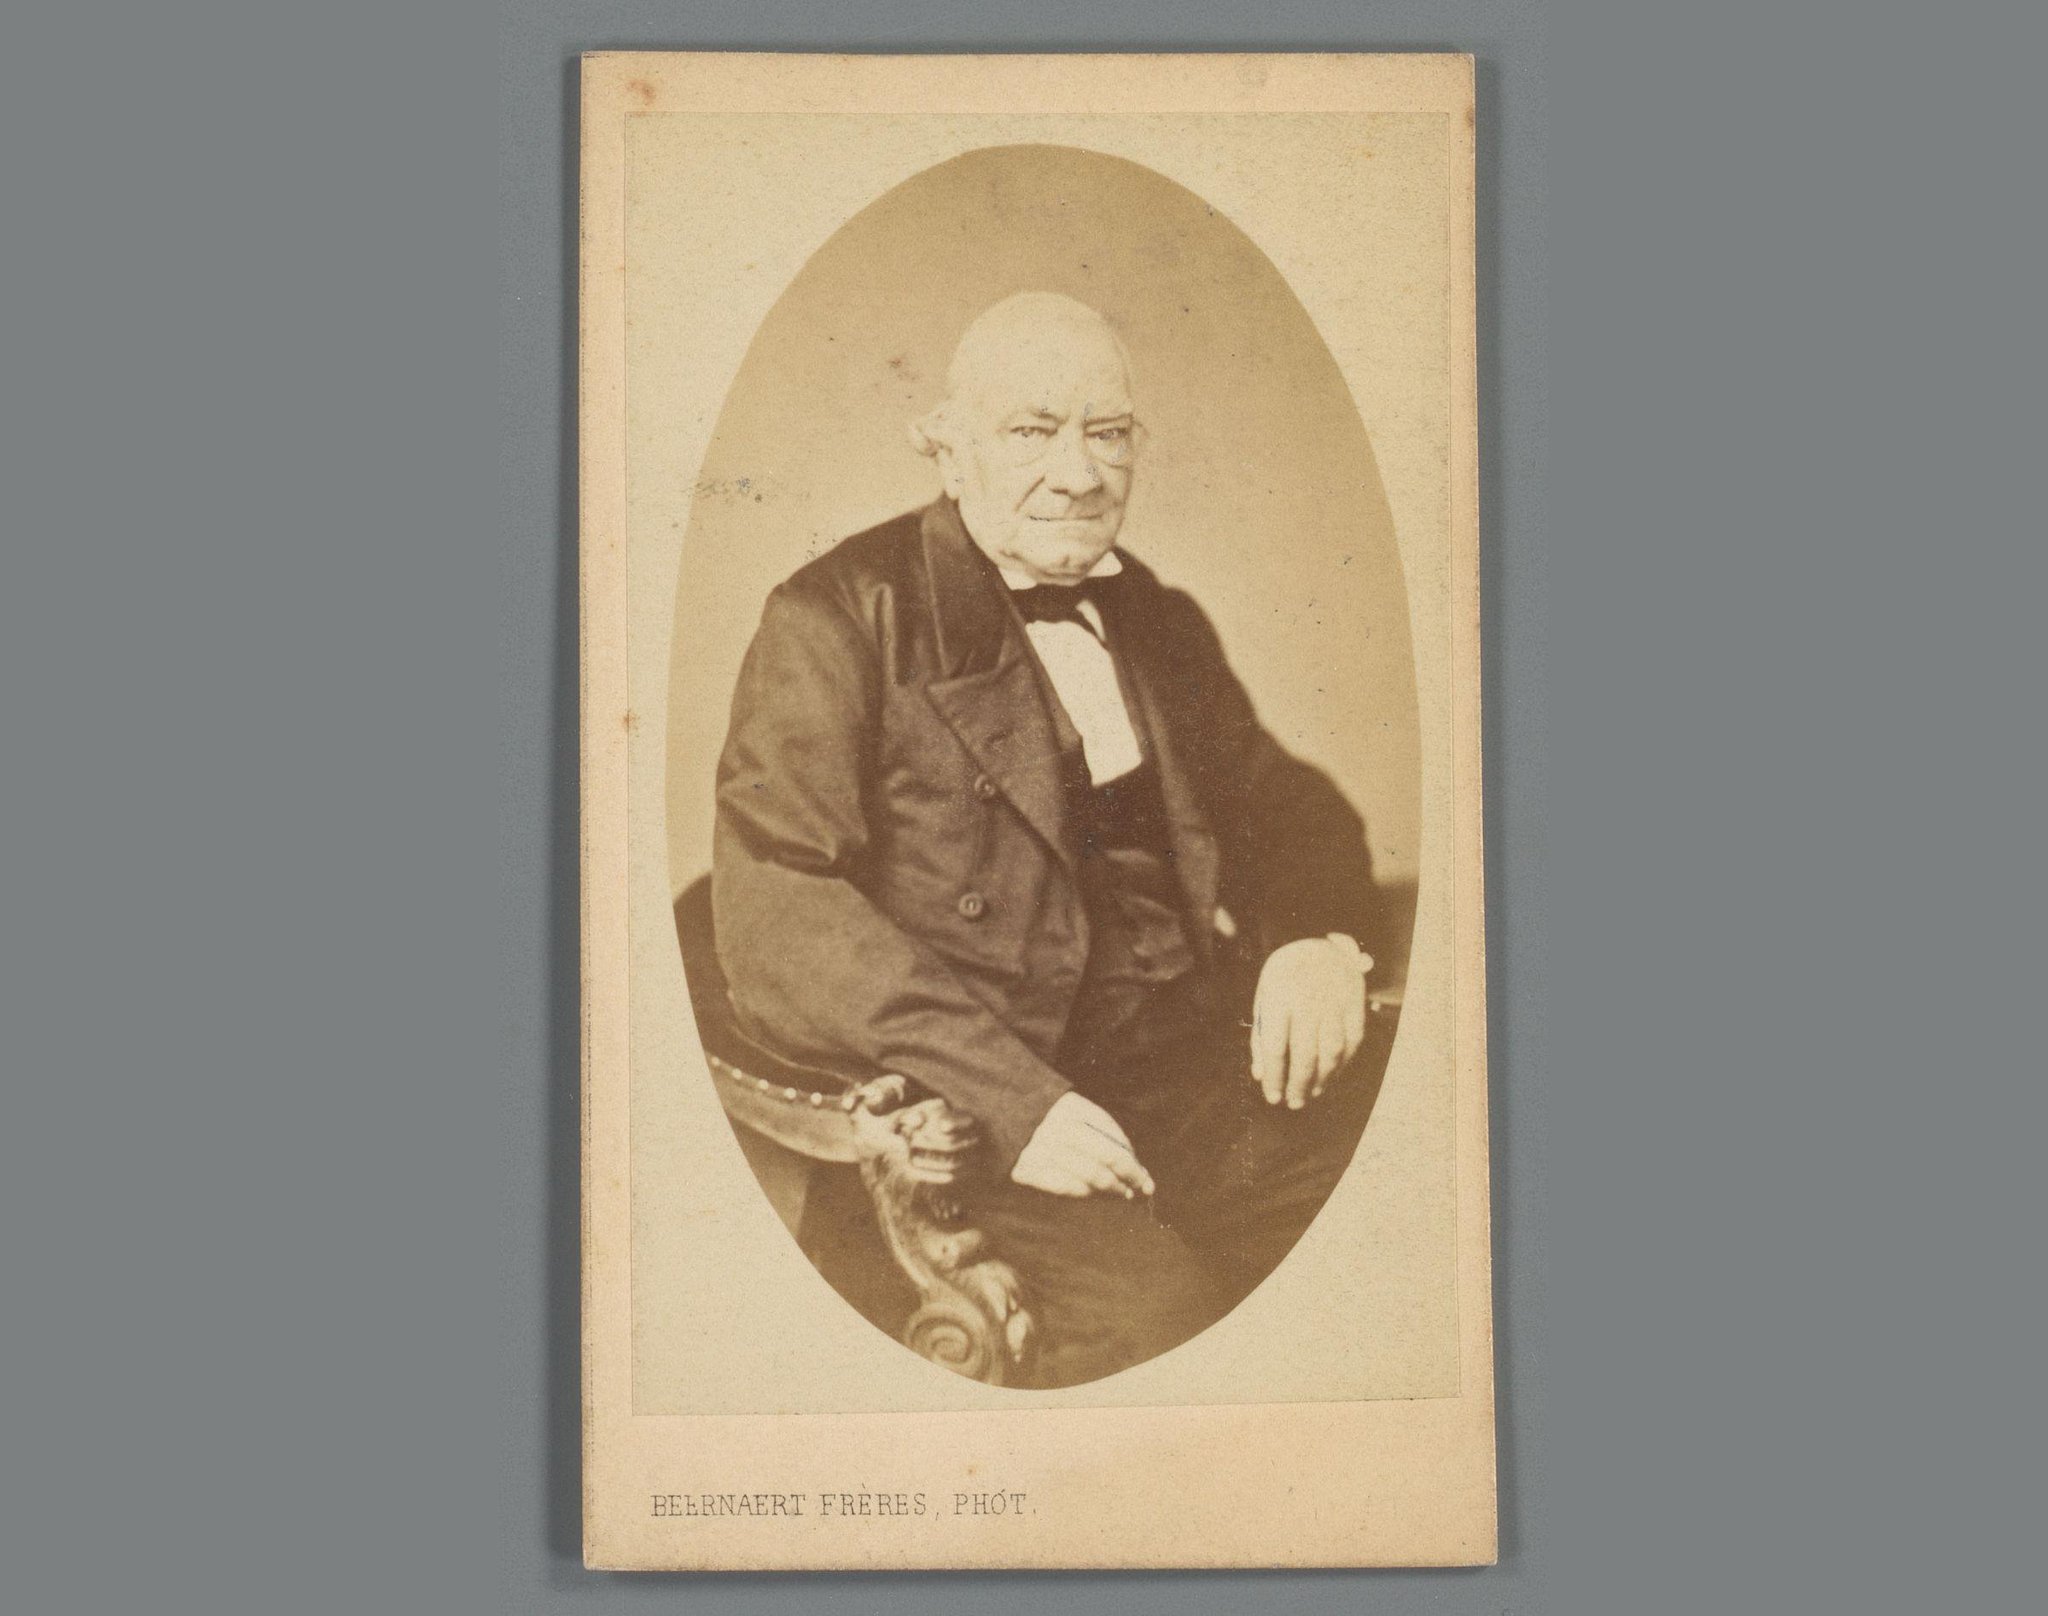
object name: prayer card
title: Portret van Pierre-François Hebbelynck op bidprent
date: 1871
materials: cardboard, paper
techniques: albumen print, letterpress printing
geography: ghent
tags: mayor, burgomaster, historical persons, old man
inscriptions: inscription: ‘Beernaert Frères, phot.’, inscription: ‘Le juste qui marche dans le sentier droit (...) R.I.P.’